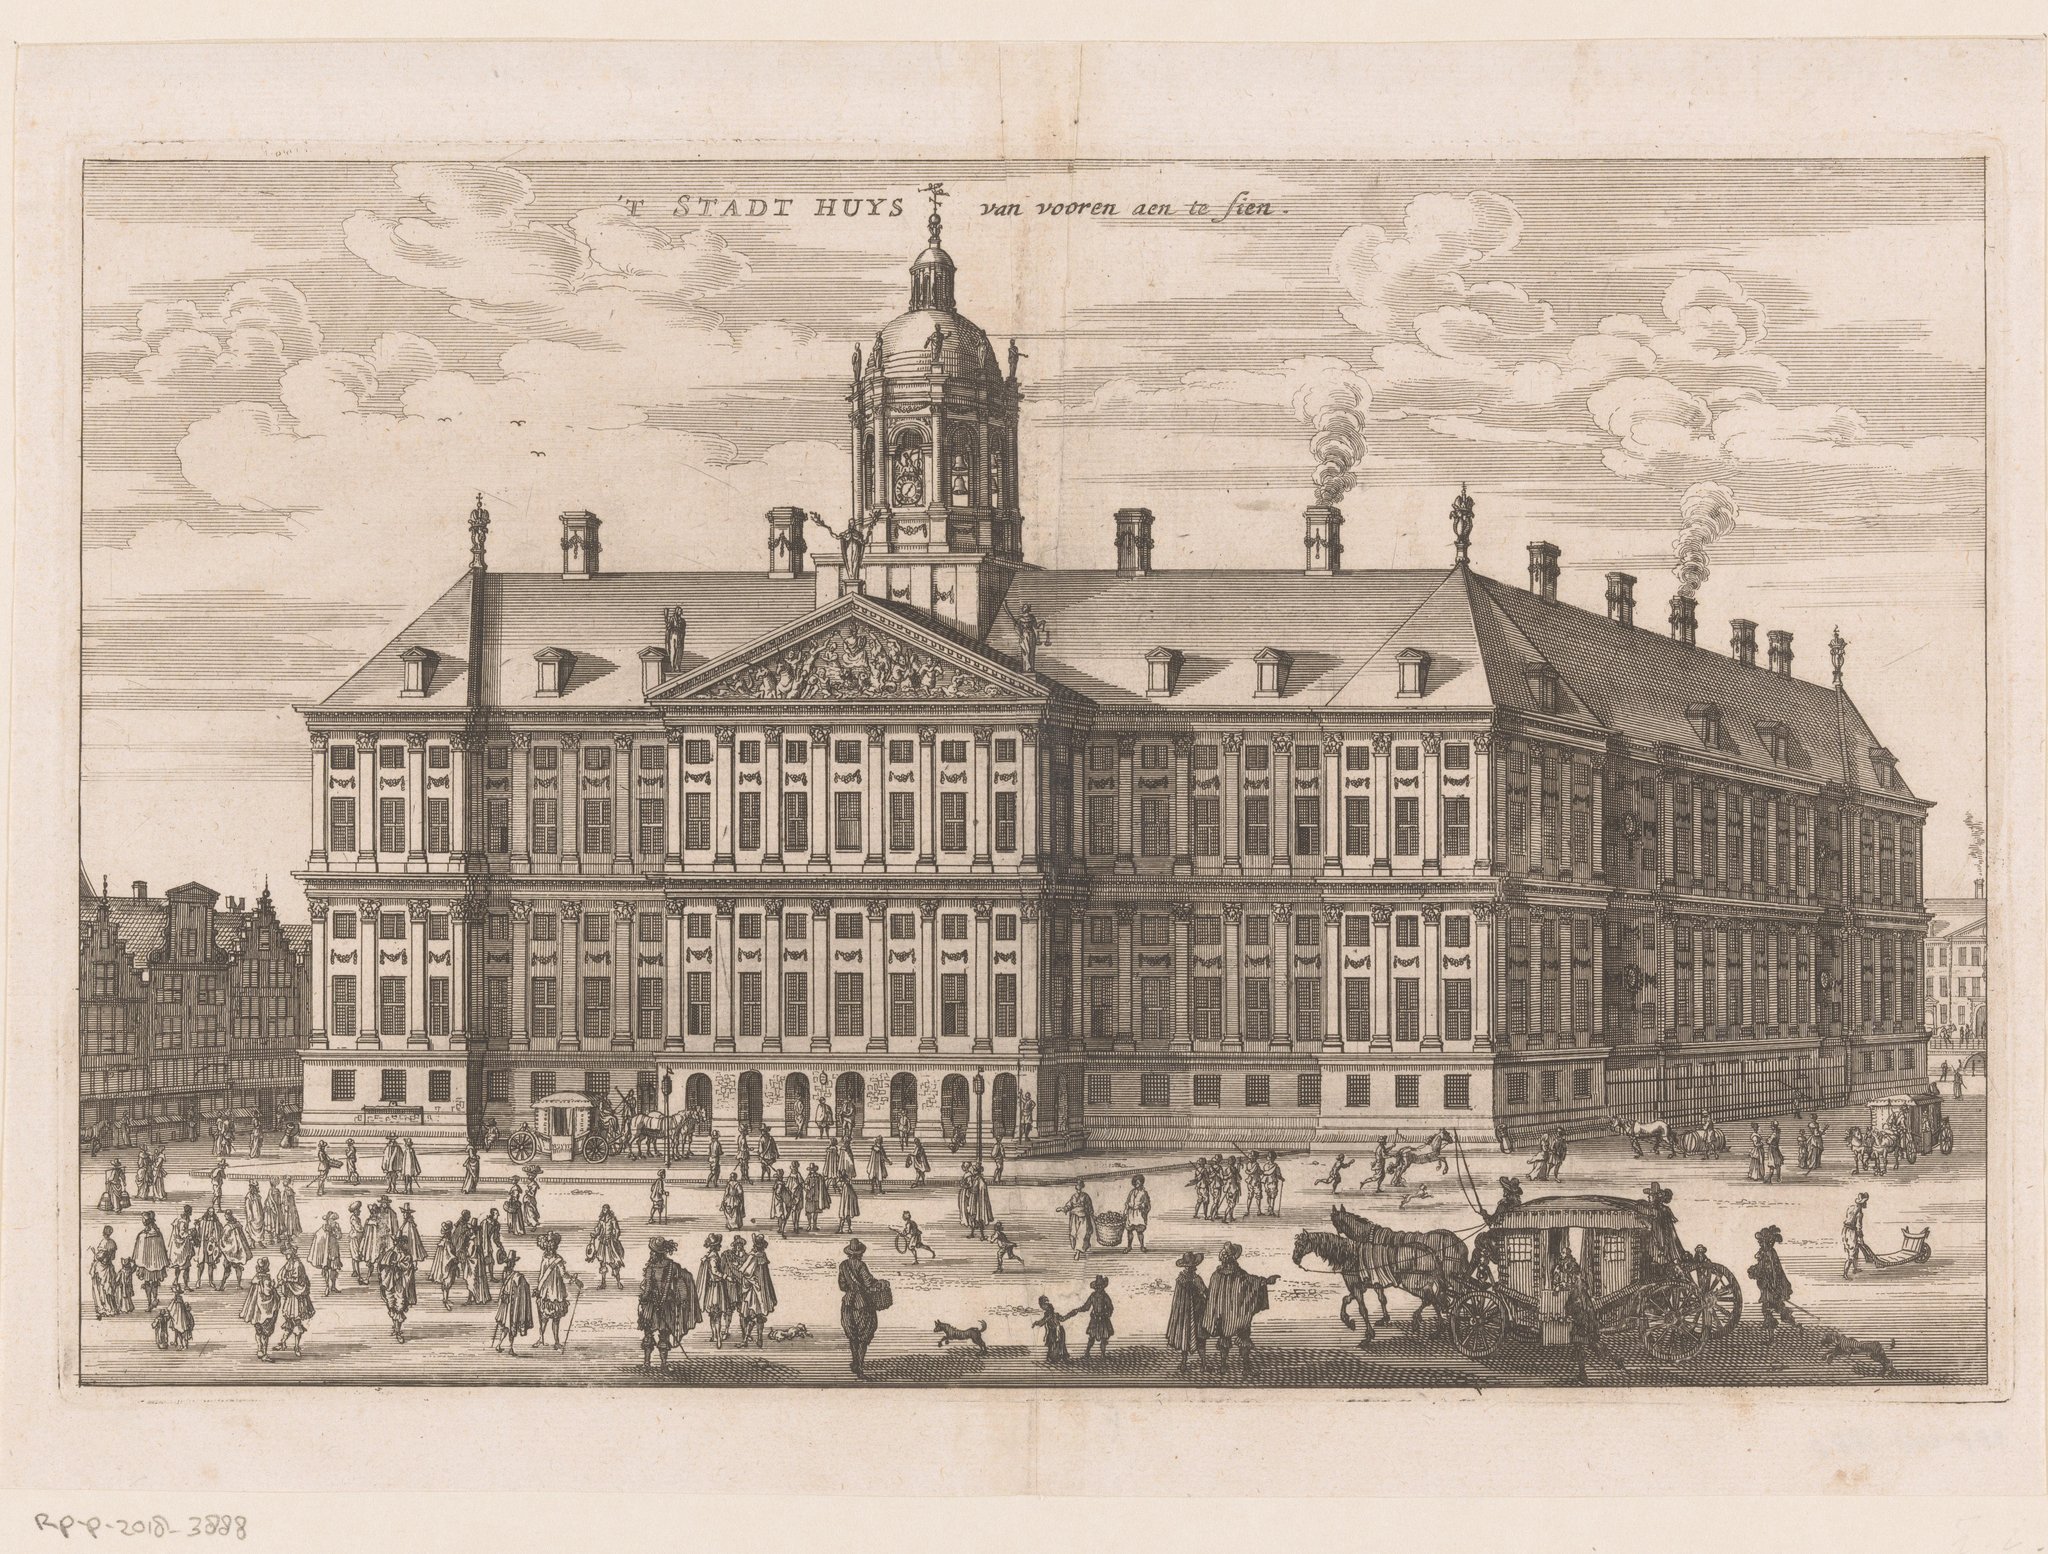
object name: print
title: Gezicht op de voorzijde van het Koninklijk Paleis te Amsterdam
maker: jacob van meurs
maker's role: draughtsman, print maker, publisher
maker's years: 1619-1680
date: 1663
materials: paper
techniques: etching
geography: amsterdam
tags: palace, royal palace of amsterdam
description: Prent verschenen in: Dapper, Olfert. Historische beschryving der stadt Amsterdam: waer in de voornaemste geschiedenissen (na een kort verhael van gansch Hollant en d'omleggende dorpen (…). Amsterdam: Jacob van Meurs, 1663.